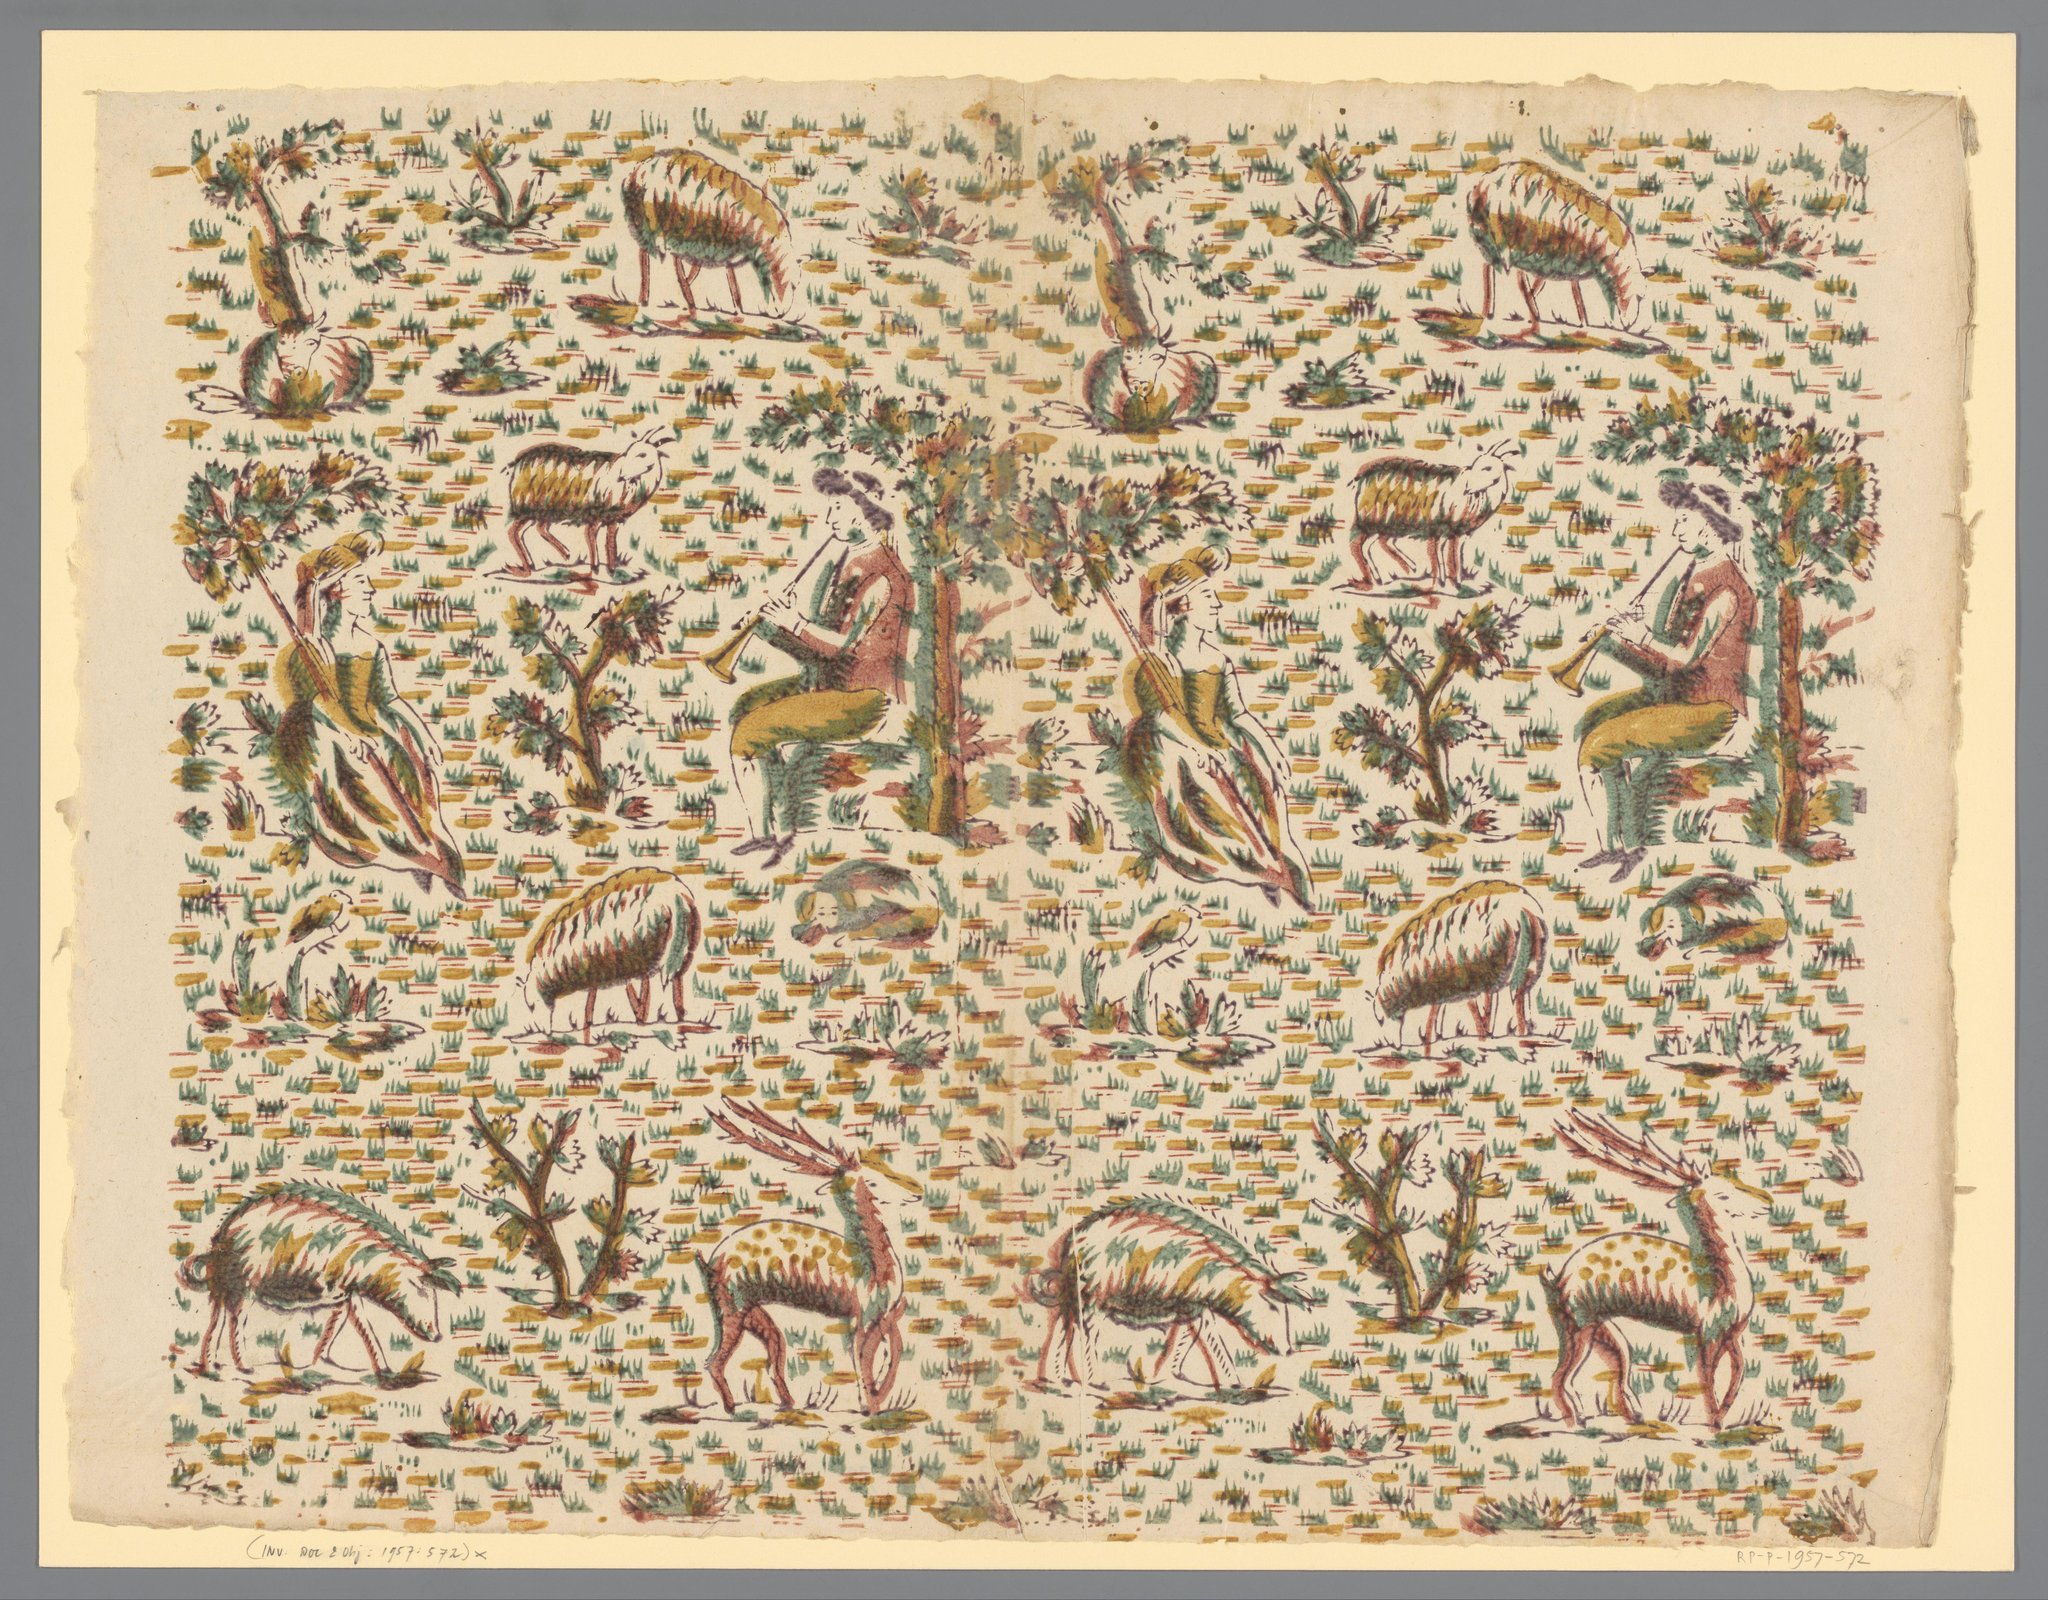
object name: printed paper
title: Blad met fluitspelende herder en zittende herderin omgeven door dieren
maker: Anonymous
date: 1780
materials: ink, paper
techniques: printing block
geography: netherlands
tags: mammals, herding, herdsman, herdswoman, shepherd, shepherdess, cowherd, etc.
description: Blad met rechts een fluitspelende herder zittend onder een boom tegenover een zittende herderin links, omgeven door verschillende dieren. Links en rechts identieke helften.